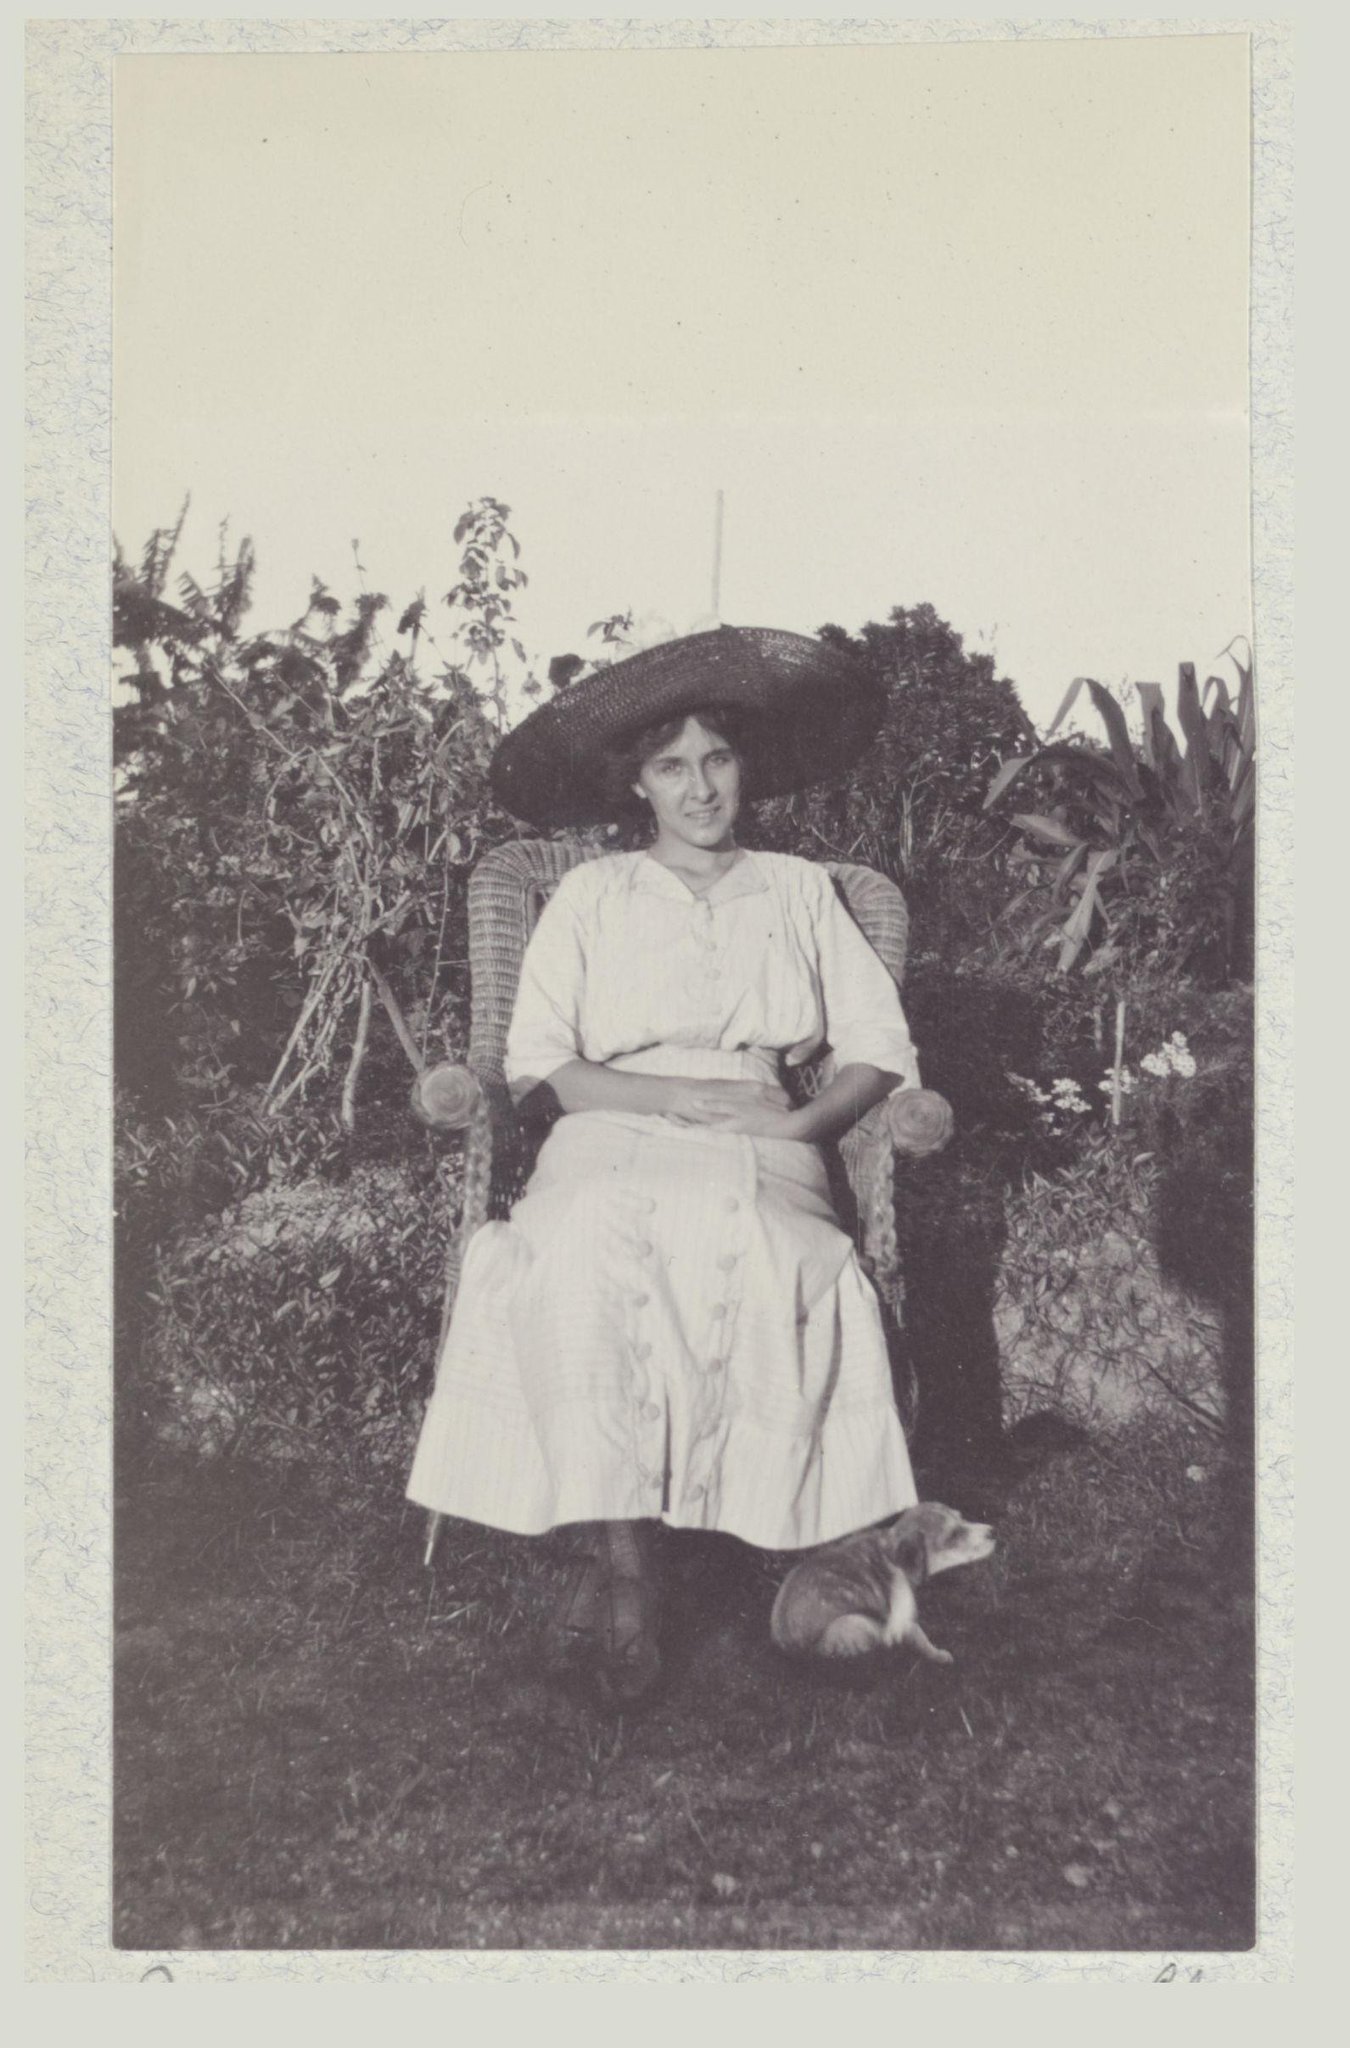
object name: photograph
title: Maria Gonggrijp met haar nieuwe hoed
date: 1909-1911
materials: photographic support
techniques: photography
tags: suriname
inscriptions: inscription: ‘Poppy met 'r nieuwe hoed, Clevia sept. '11’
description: Maria Gonggrijp zittend in een stoel met een grote zonnehoed op het hoofd. Bij haar voeten een hond. Op Plantage Clevia, september 1911. Onderdeel van het fotoalbum van de familie Boom-Gonggrijp in Suriname en Curaçao.